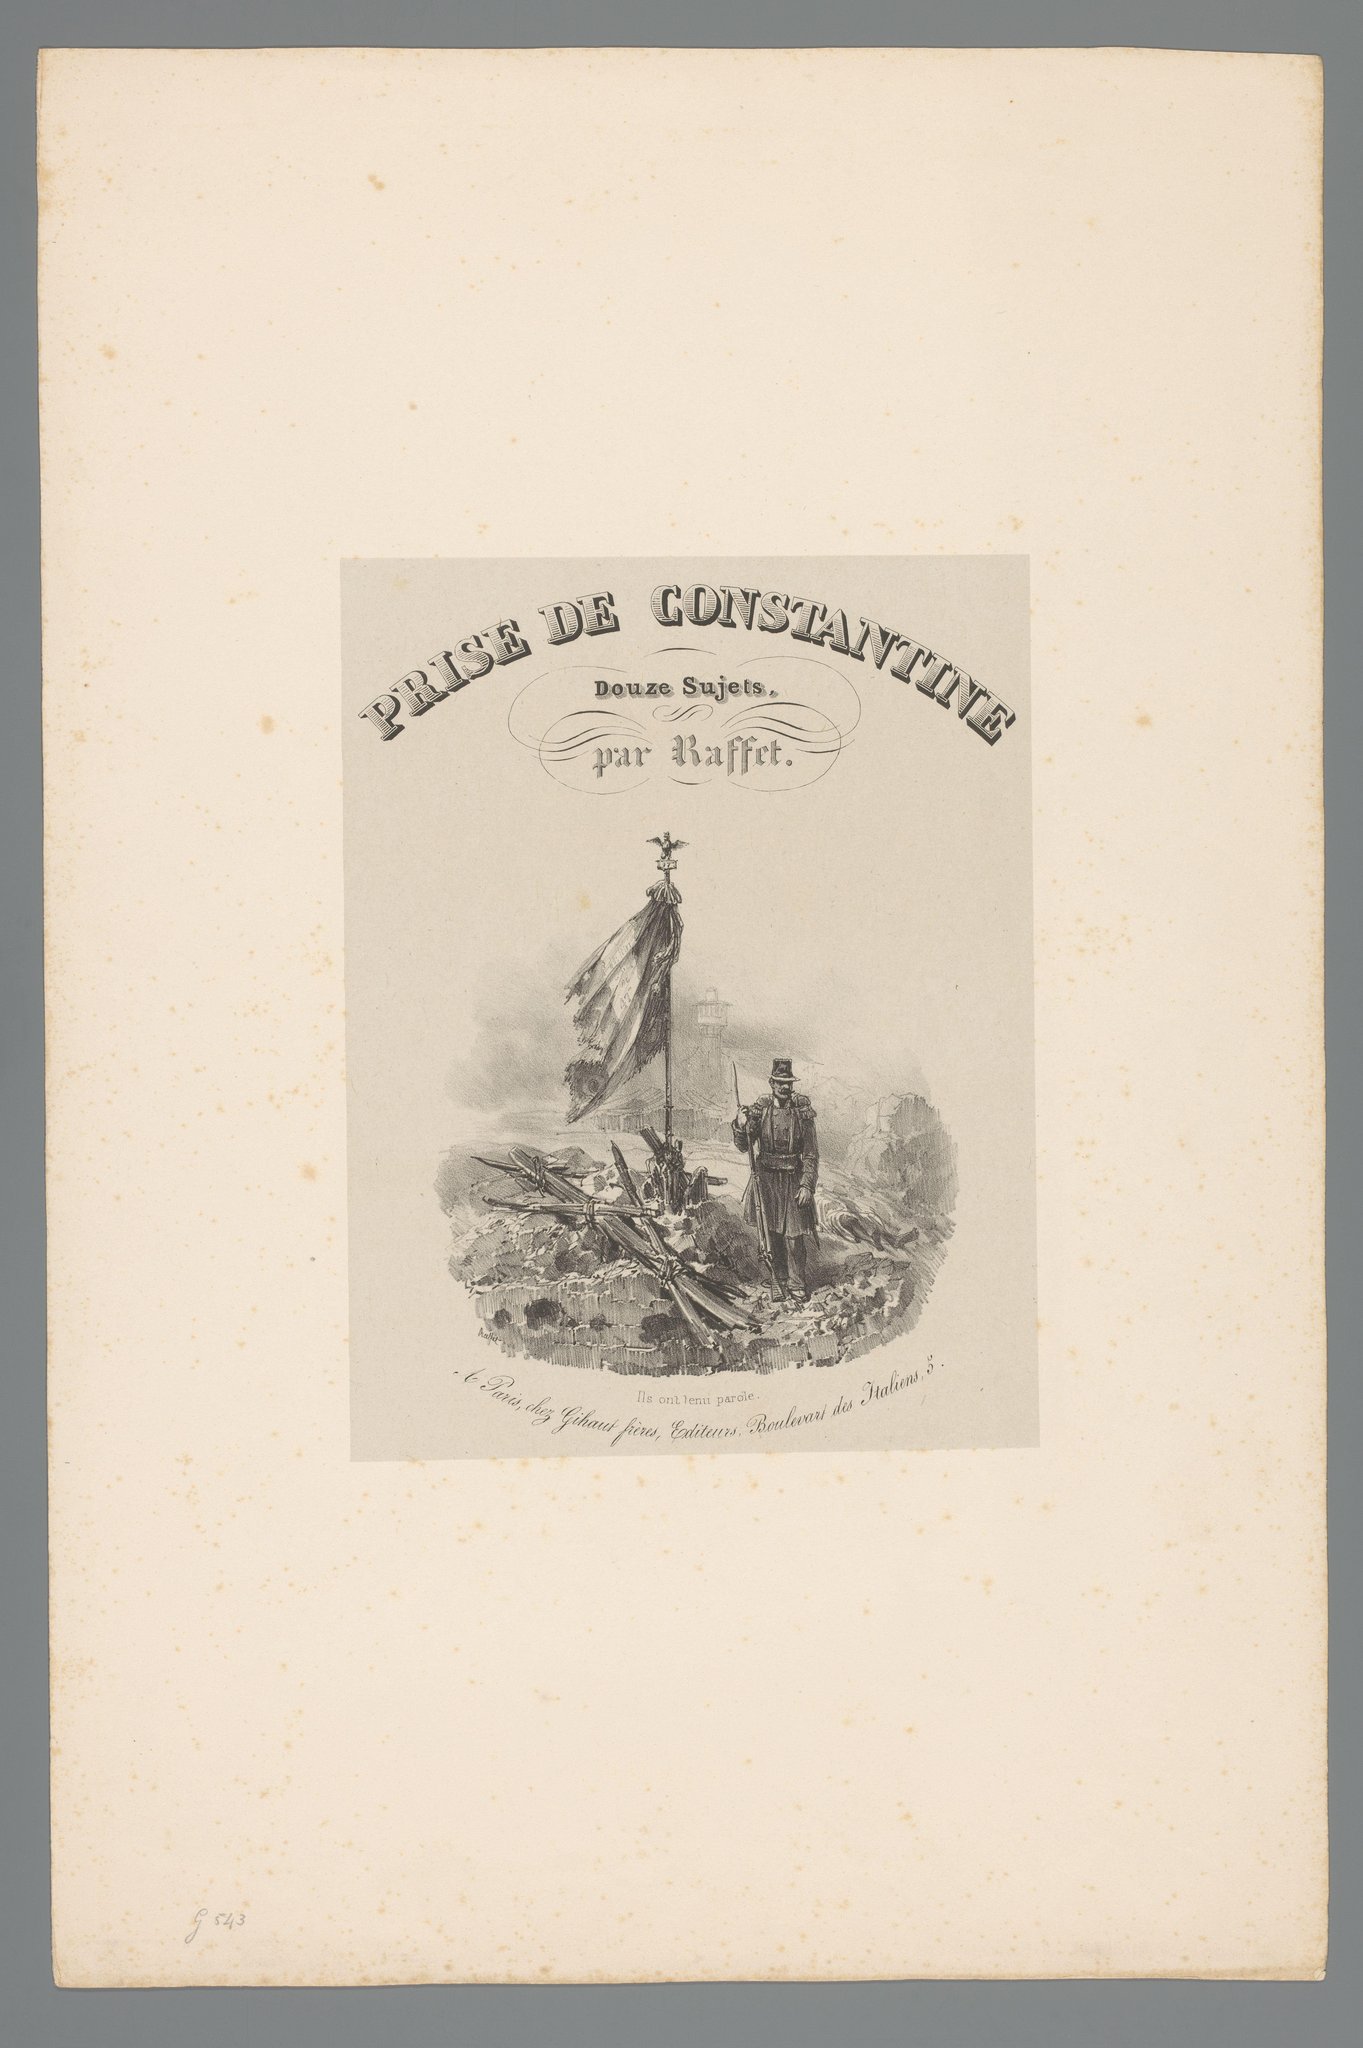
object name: print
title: Titelprent van twaalf prenten over de inname van Constantine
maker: denis auguste marie raffet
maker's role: draughtsman, print maker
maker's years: 1804-1860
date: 1838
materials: paper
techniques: lithograph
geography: paris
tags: the soldier; the soldier's life, (military) flags and standards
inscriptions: collector's mark: Lugt 964